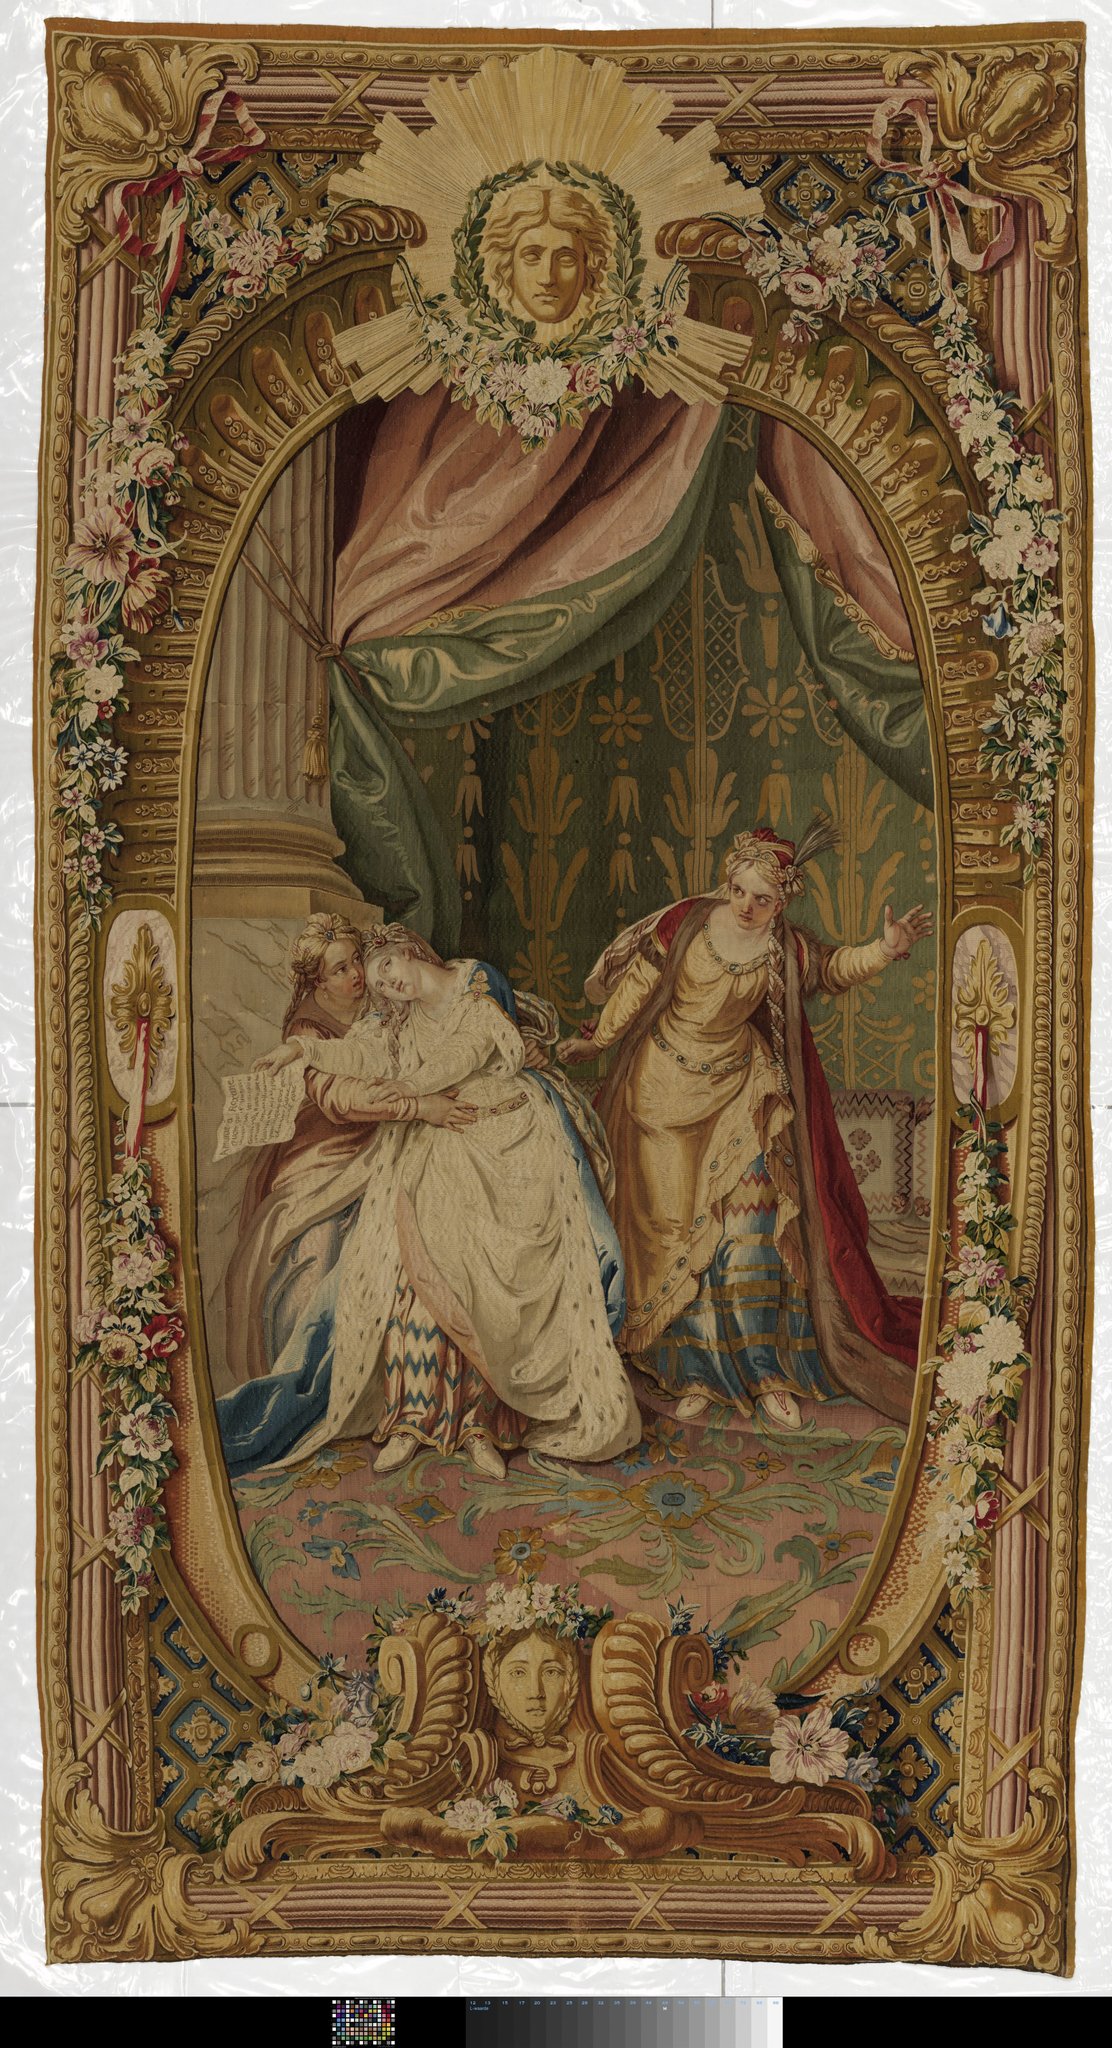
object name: tapestry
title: Tapestry with Roxane and Atalide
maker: michel audran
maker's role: wever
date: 1776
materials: silk, wool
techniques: tapestry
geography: paris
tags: fainting, swooning, theatre, theatrical performance, mask, mascaron ~ ornament, lover with love-letter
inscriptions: date: ‘1776’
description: Depicted here is a scene from Bajazet, a play by the 17th-century French writer Jean Racine. This tapestry is part of a series with scenes from operas, comedies and tragedies designed by Coypel in 1748. Six sets were woven in total. This tapestry belongs to the last set. Such series served as decoration for formal rooms, particularly in palaces.